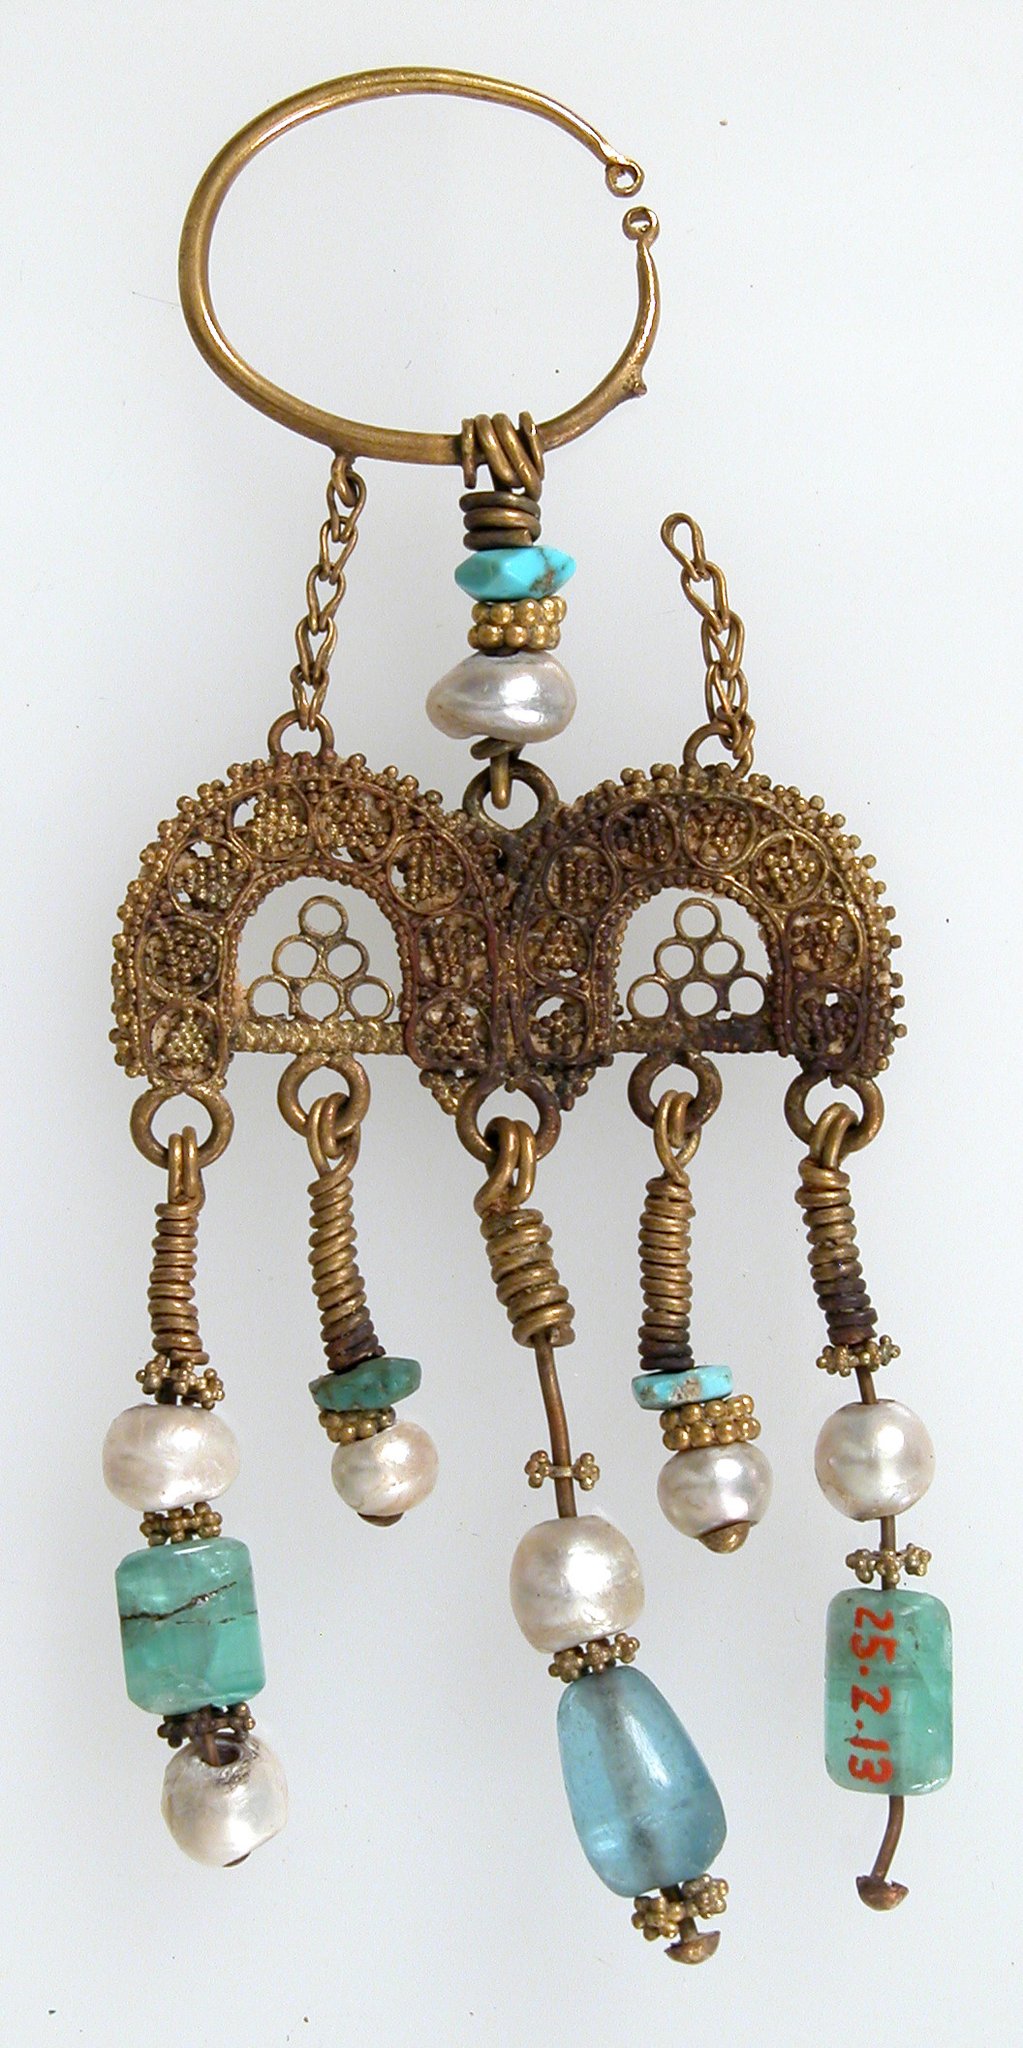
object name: earring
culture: coptic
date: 101-300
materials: gold, stone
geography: egypt